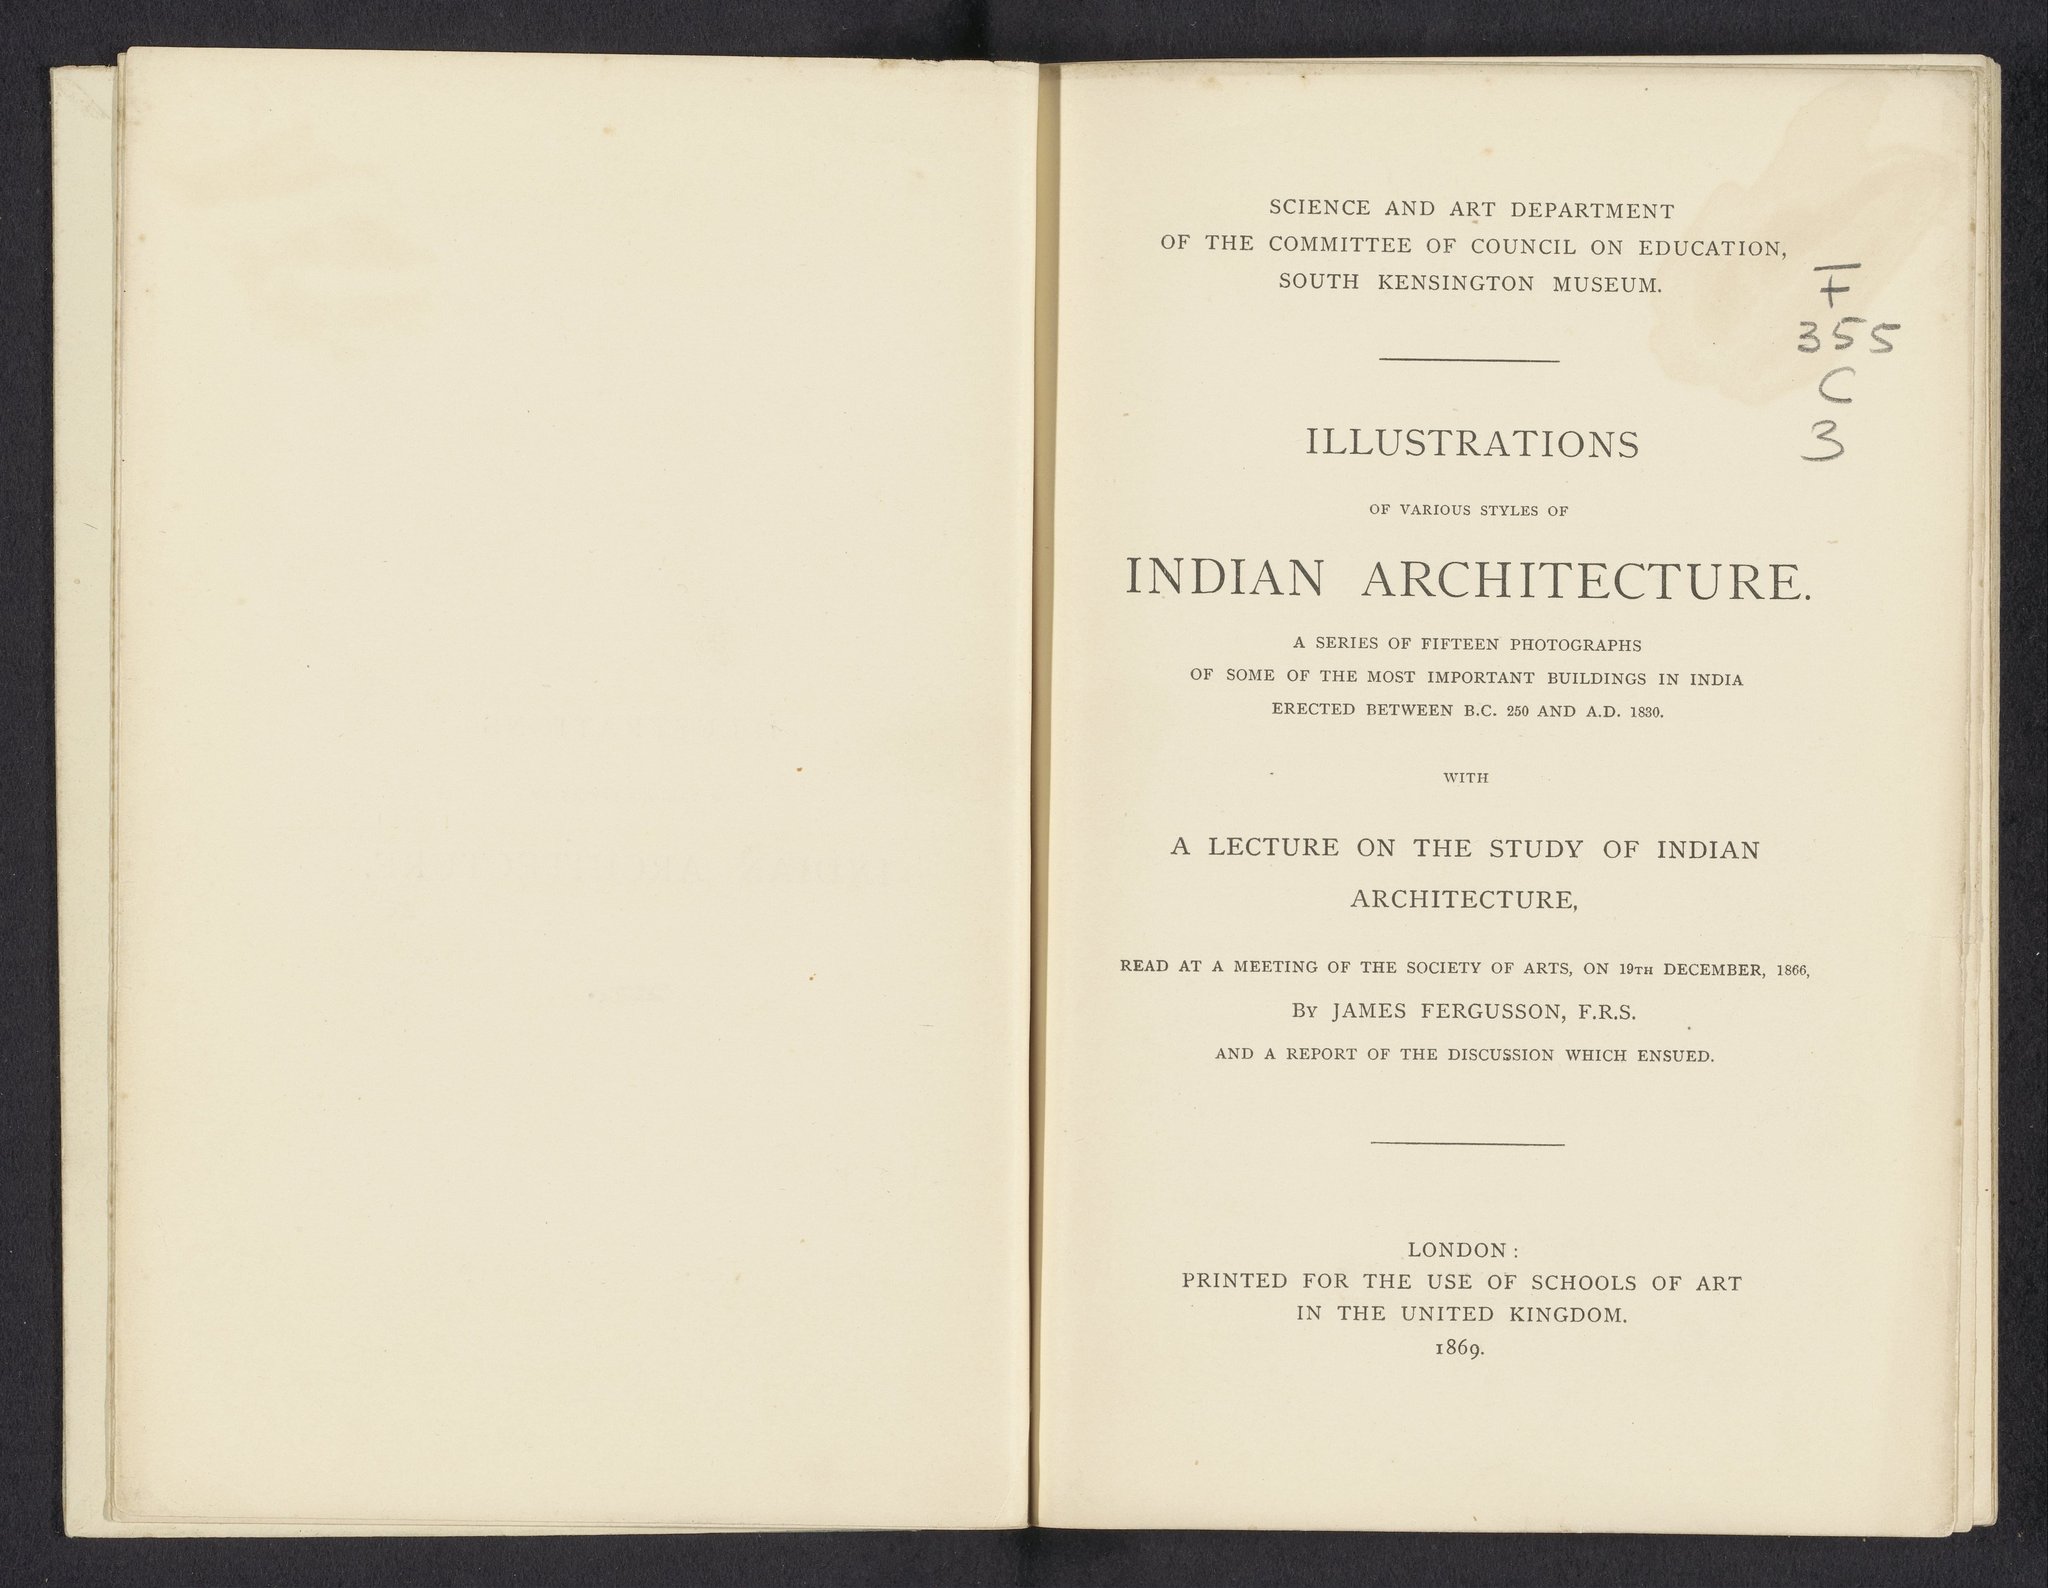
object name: book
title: Illustrations of various styles of Indian architecture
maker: james fergusson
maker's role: architect, kunsthistoricus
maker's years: 1808-1866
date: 1869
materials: cardboard, leather, paper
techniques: albumen print, printing, woodburytype